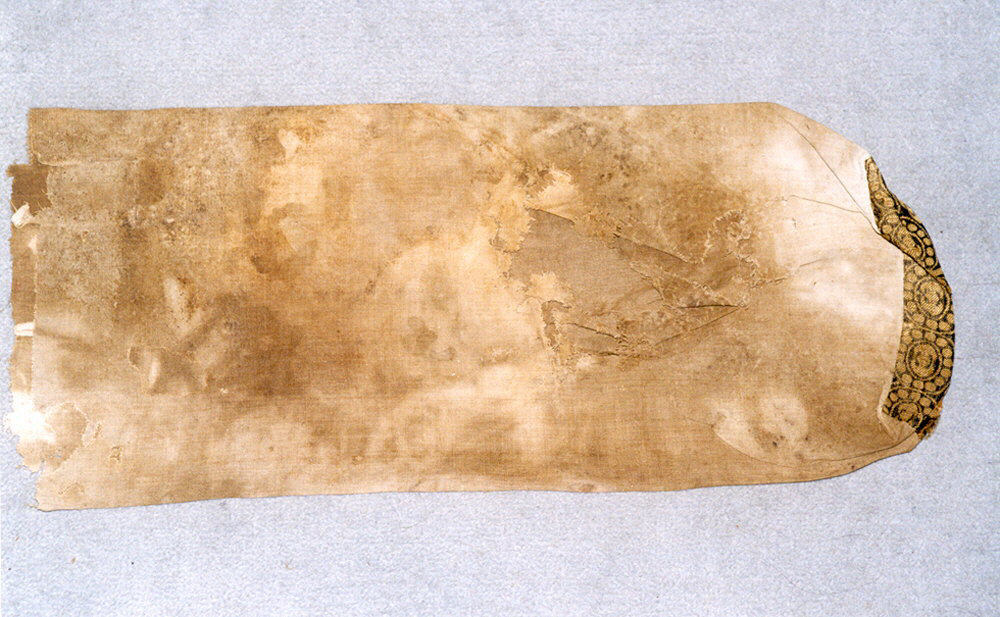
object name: pillow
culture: alanic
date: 601-900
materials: linen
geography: caucasus